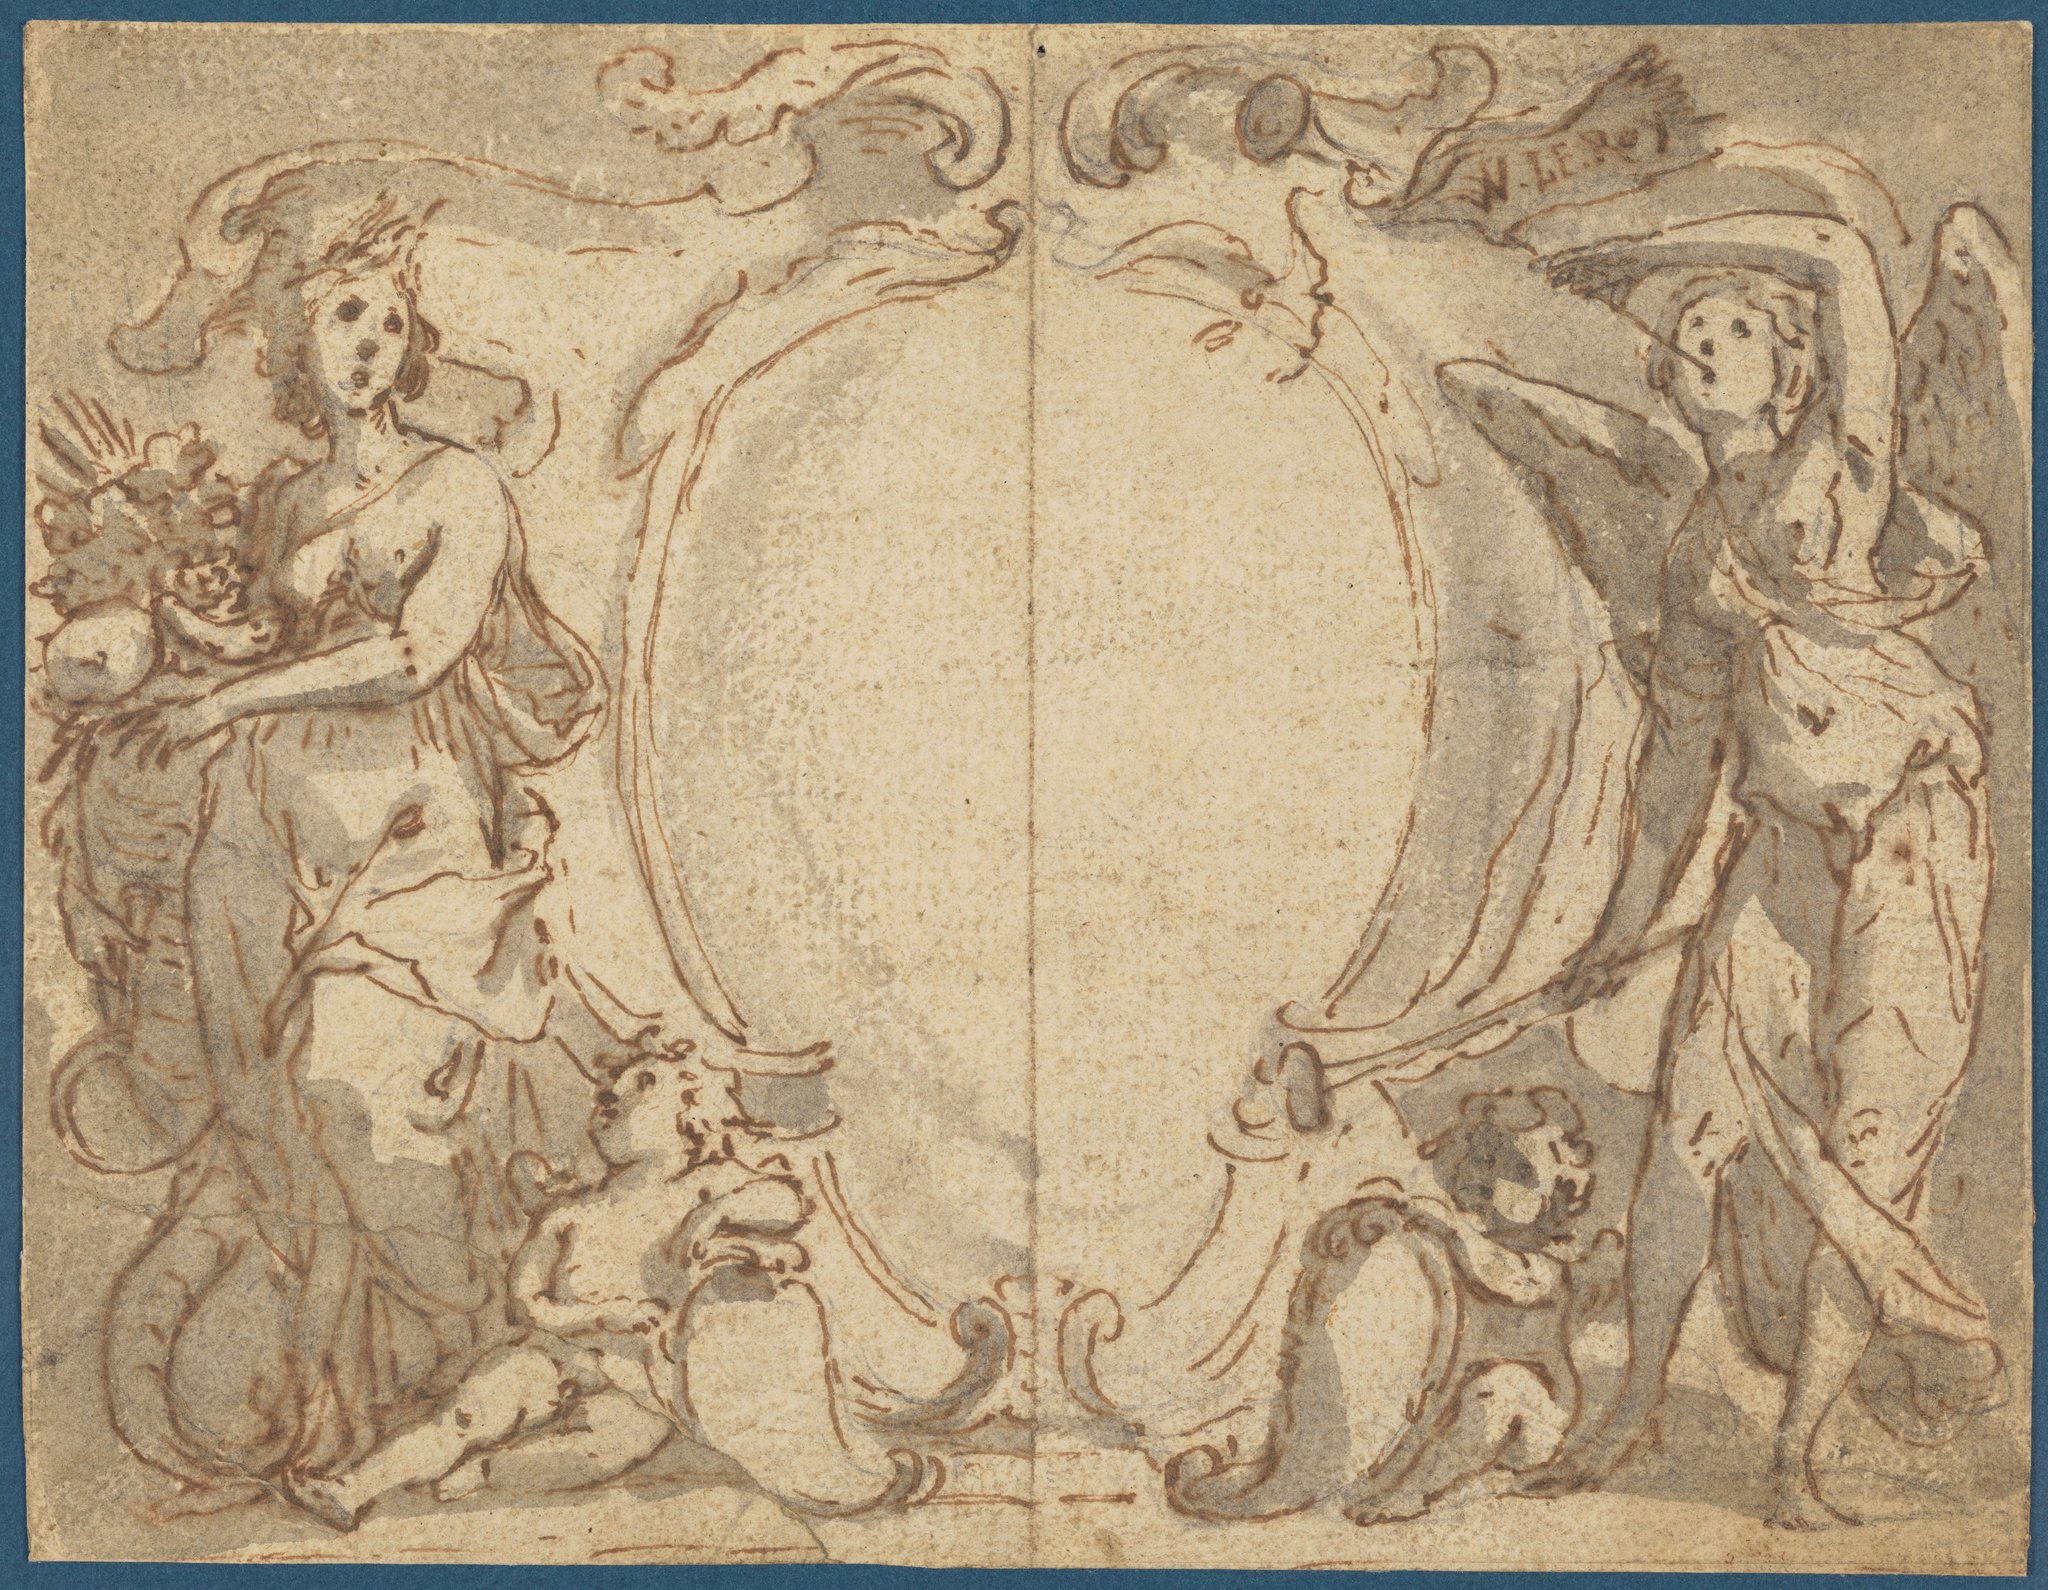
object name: drawing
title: Design for a frontispiece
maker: abraham bloemaert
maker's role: artist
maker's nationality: netherlandish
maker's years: 1566-1651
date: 1617-1625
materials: chalk, ink, paper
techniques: pen, wash